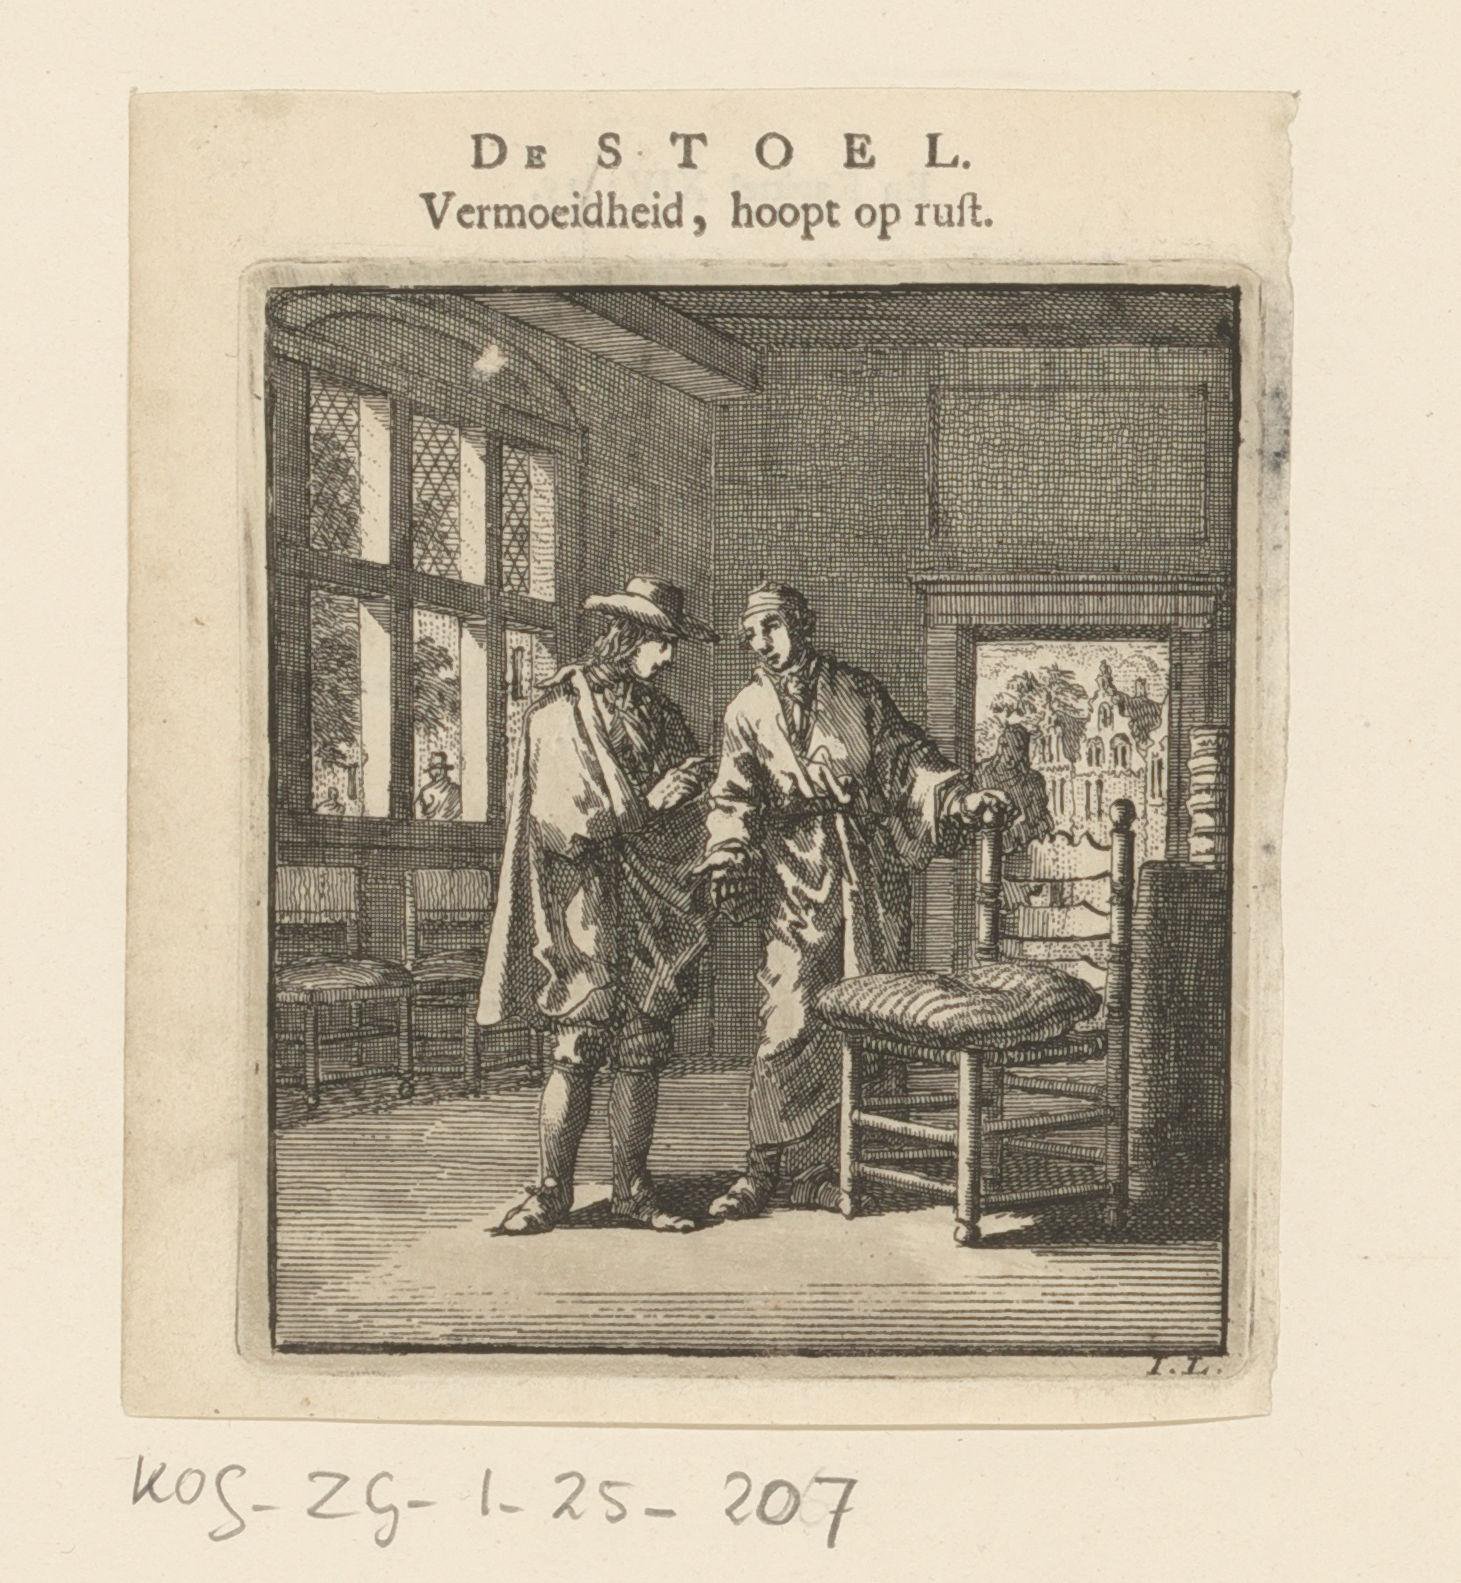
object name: print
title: Man toont een stoel met rieten zitting en een kussen aan een andere man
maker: jan luyken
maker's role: draughtsman, print maker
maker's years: 1649-1712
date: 1711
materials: paper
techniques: etching, letterpress printing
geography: amsterdam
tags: pillow, chair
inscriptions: collector's mark: Lugt 1641, stamp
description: Prent uit: Luyken, Jan. Het leerzaam huisraad, vertoond in vyftig konstige figuuren, met godlyke spreuken en stichtelyke verzen. Amsterdam: weduwe Pieter Arentsz. II en Cornelis van der Sys, 1711, p. 6.